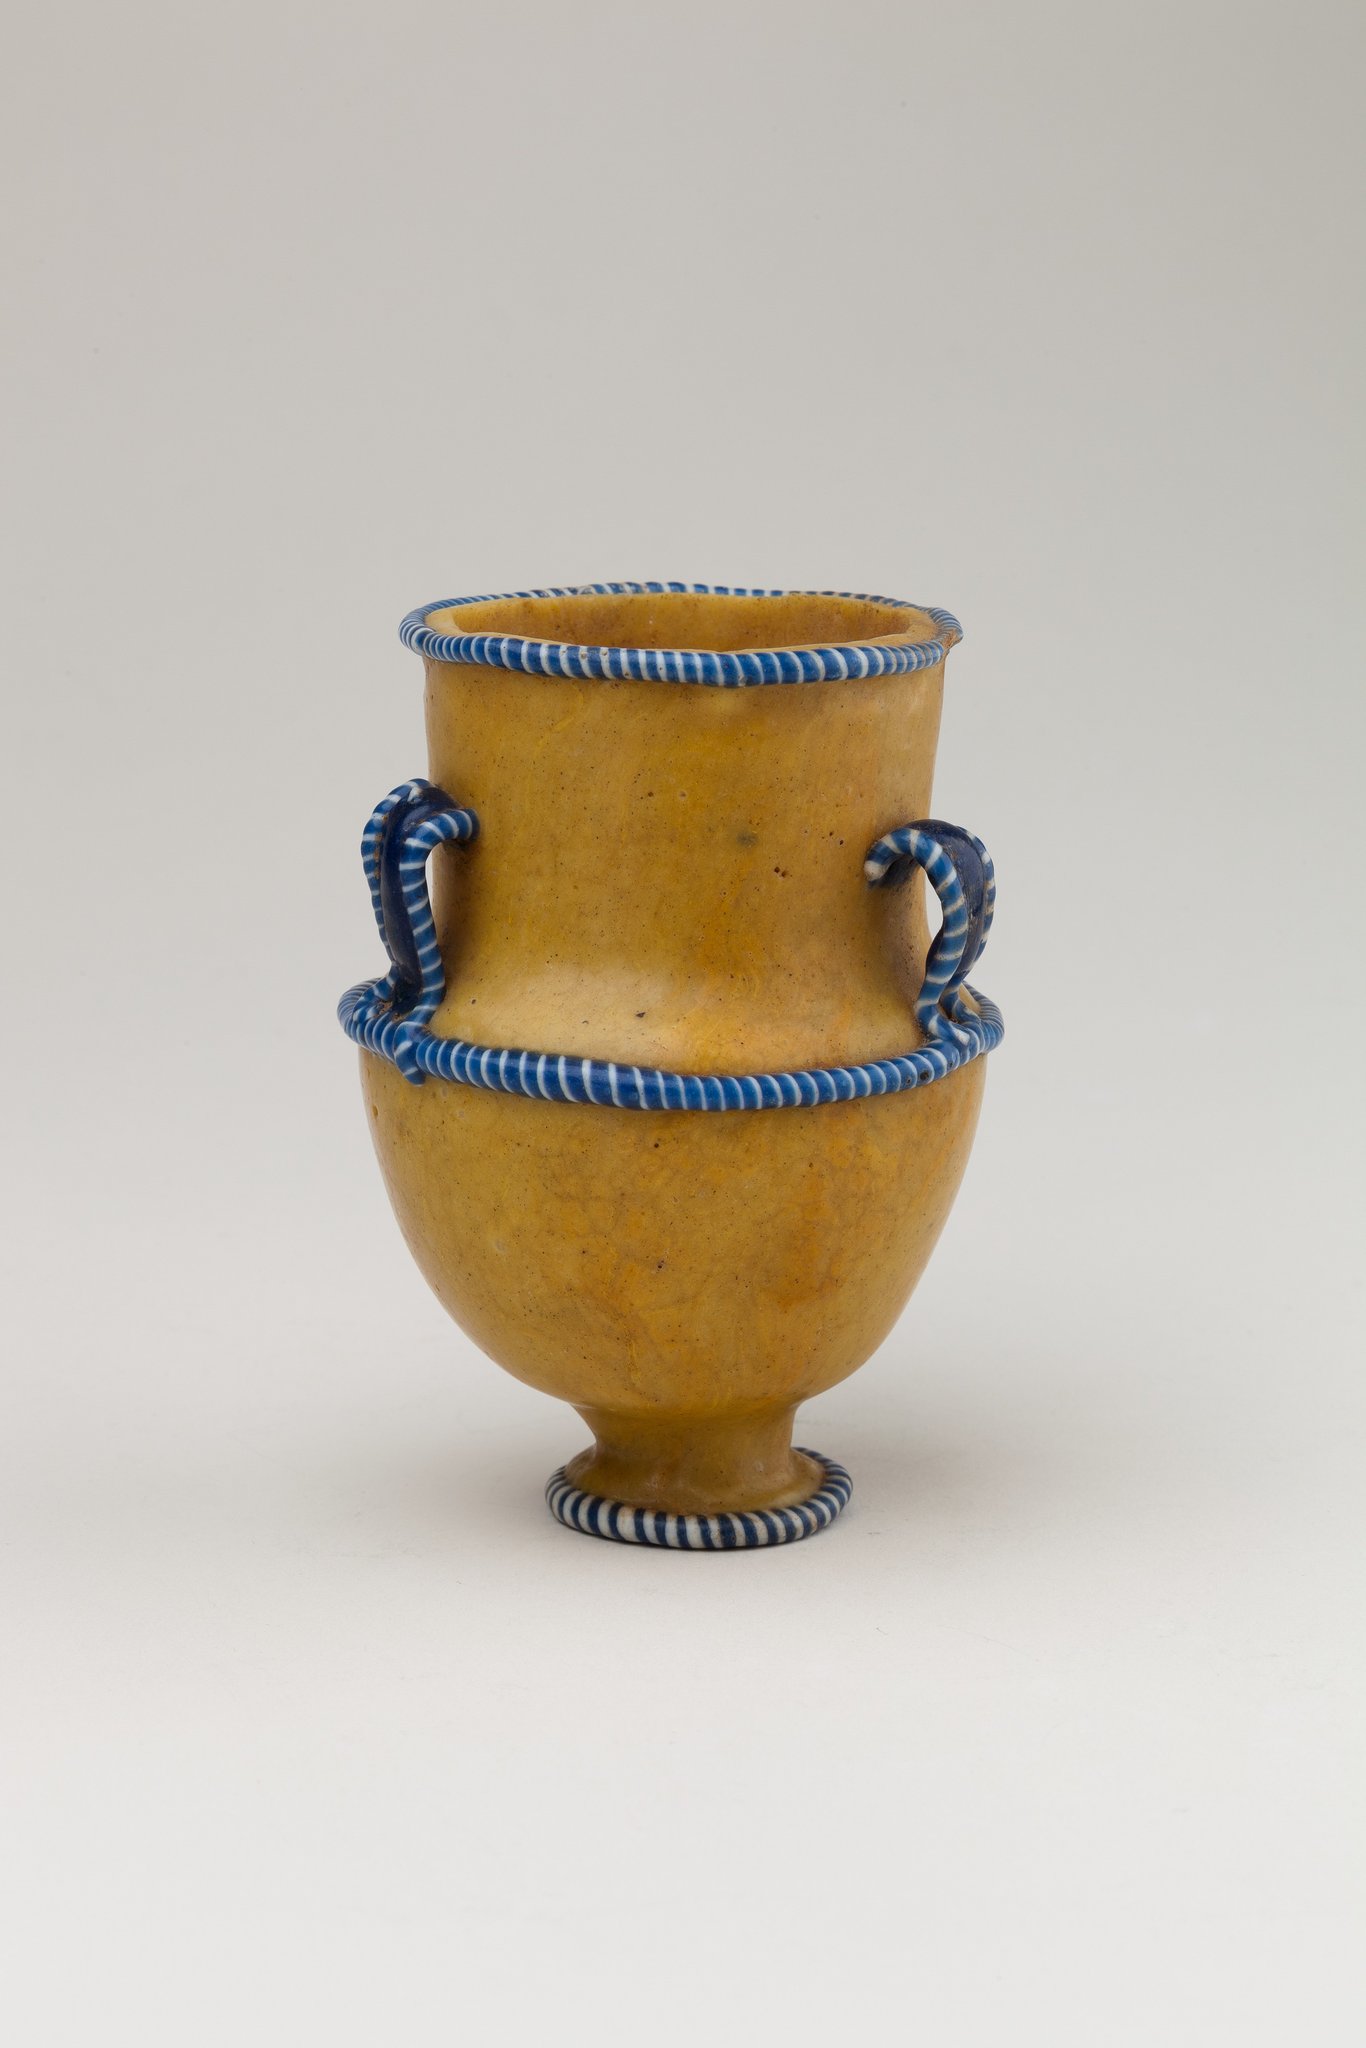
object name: vase, polychrome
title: Vase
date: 1295-1070 BCE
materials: glass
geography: egypt